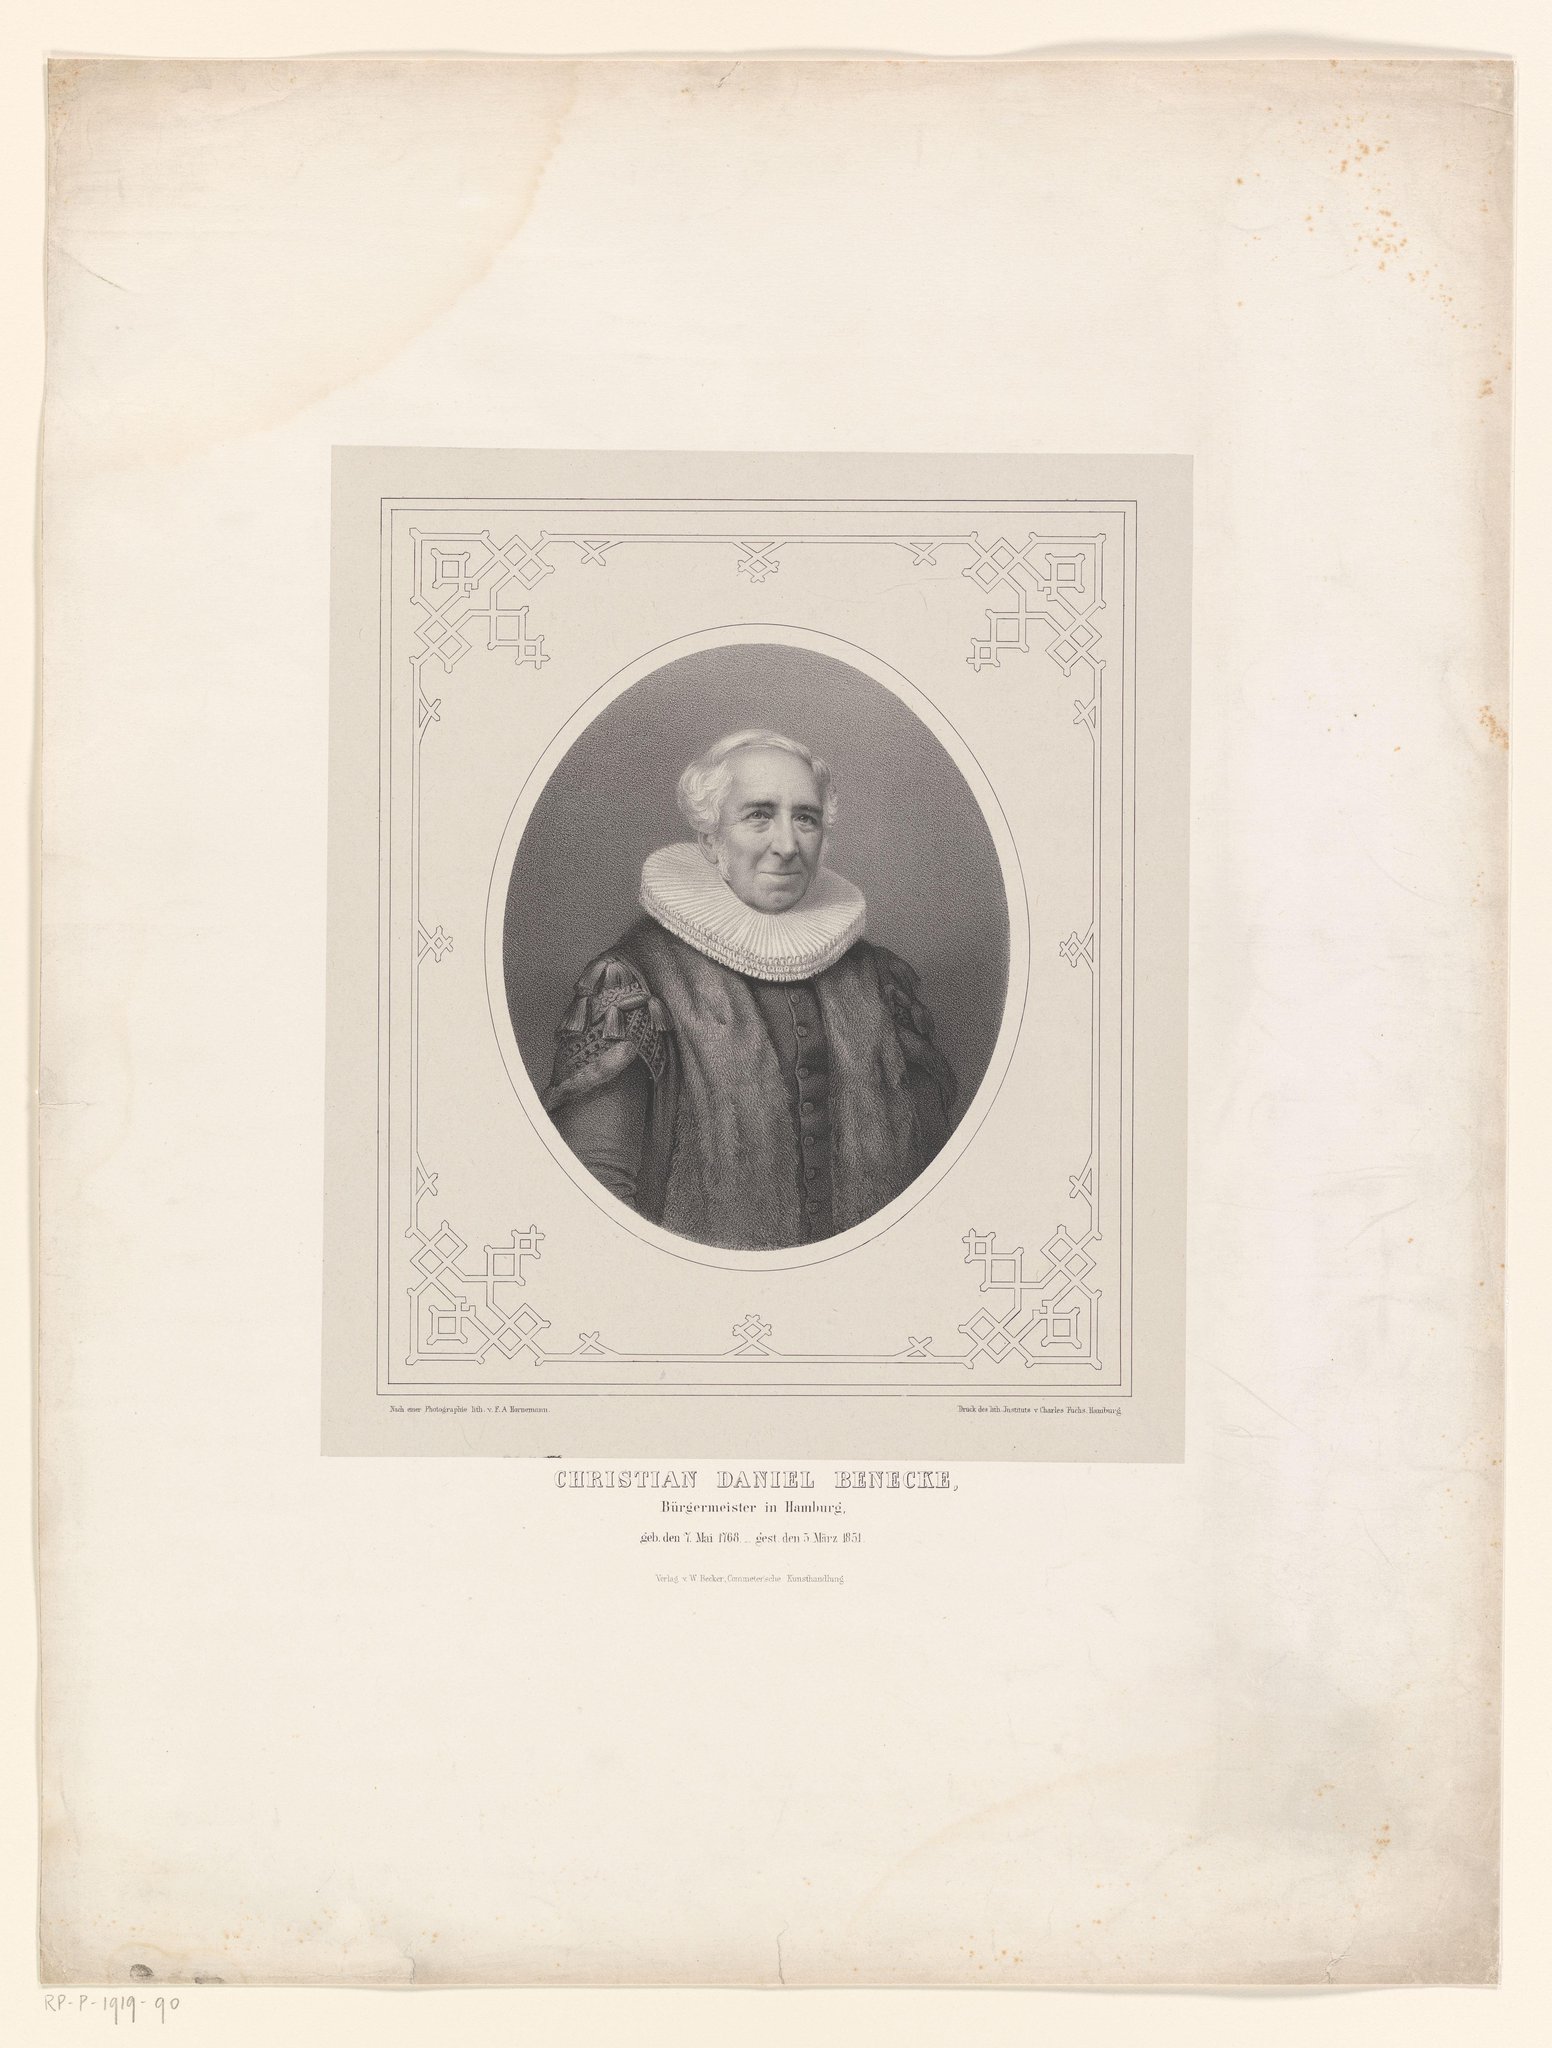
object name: print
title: Christian Daniel Benecke, Bürgermeister in Hamburg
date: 1851-1890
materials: paper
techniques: lithograph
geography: hamburg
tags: adult man, historical persons, neck-gear: collar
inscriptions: collector's mark: Lugt 2228